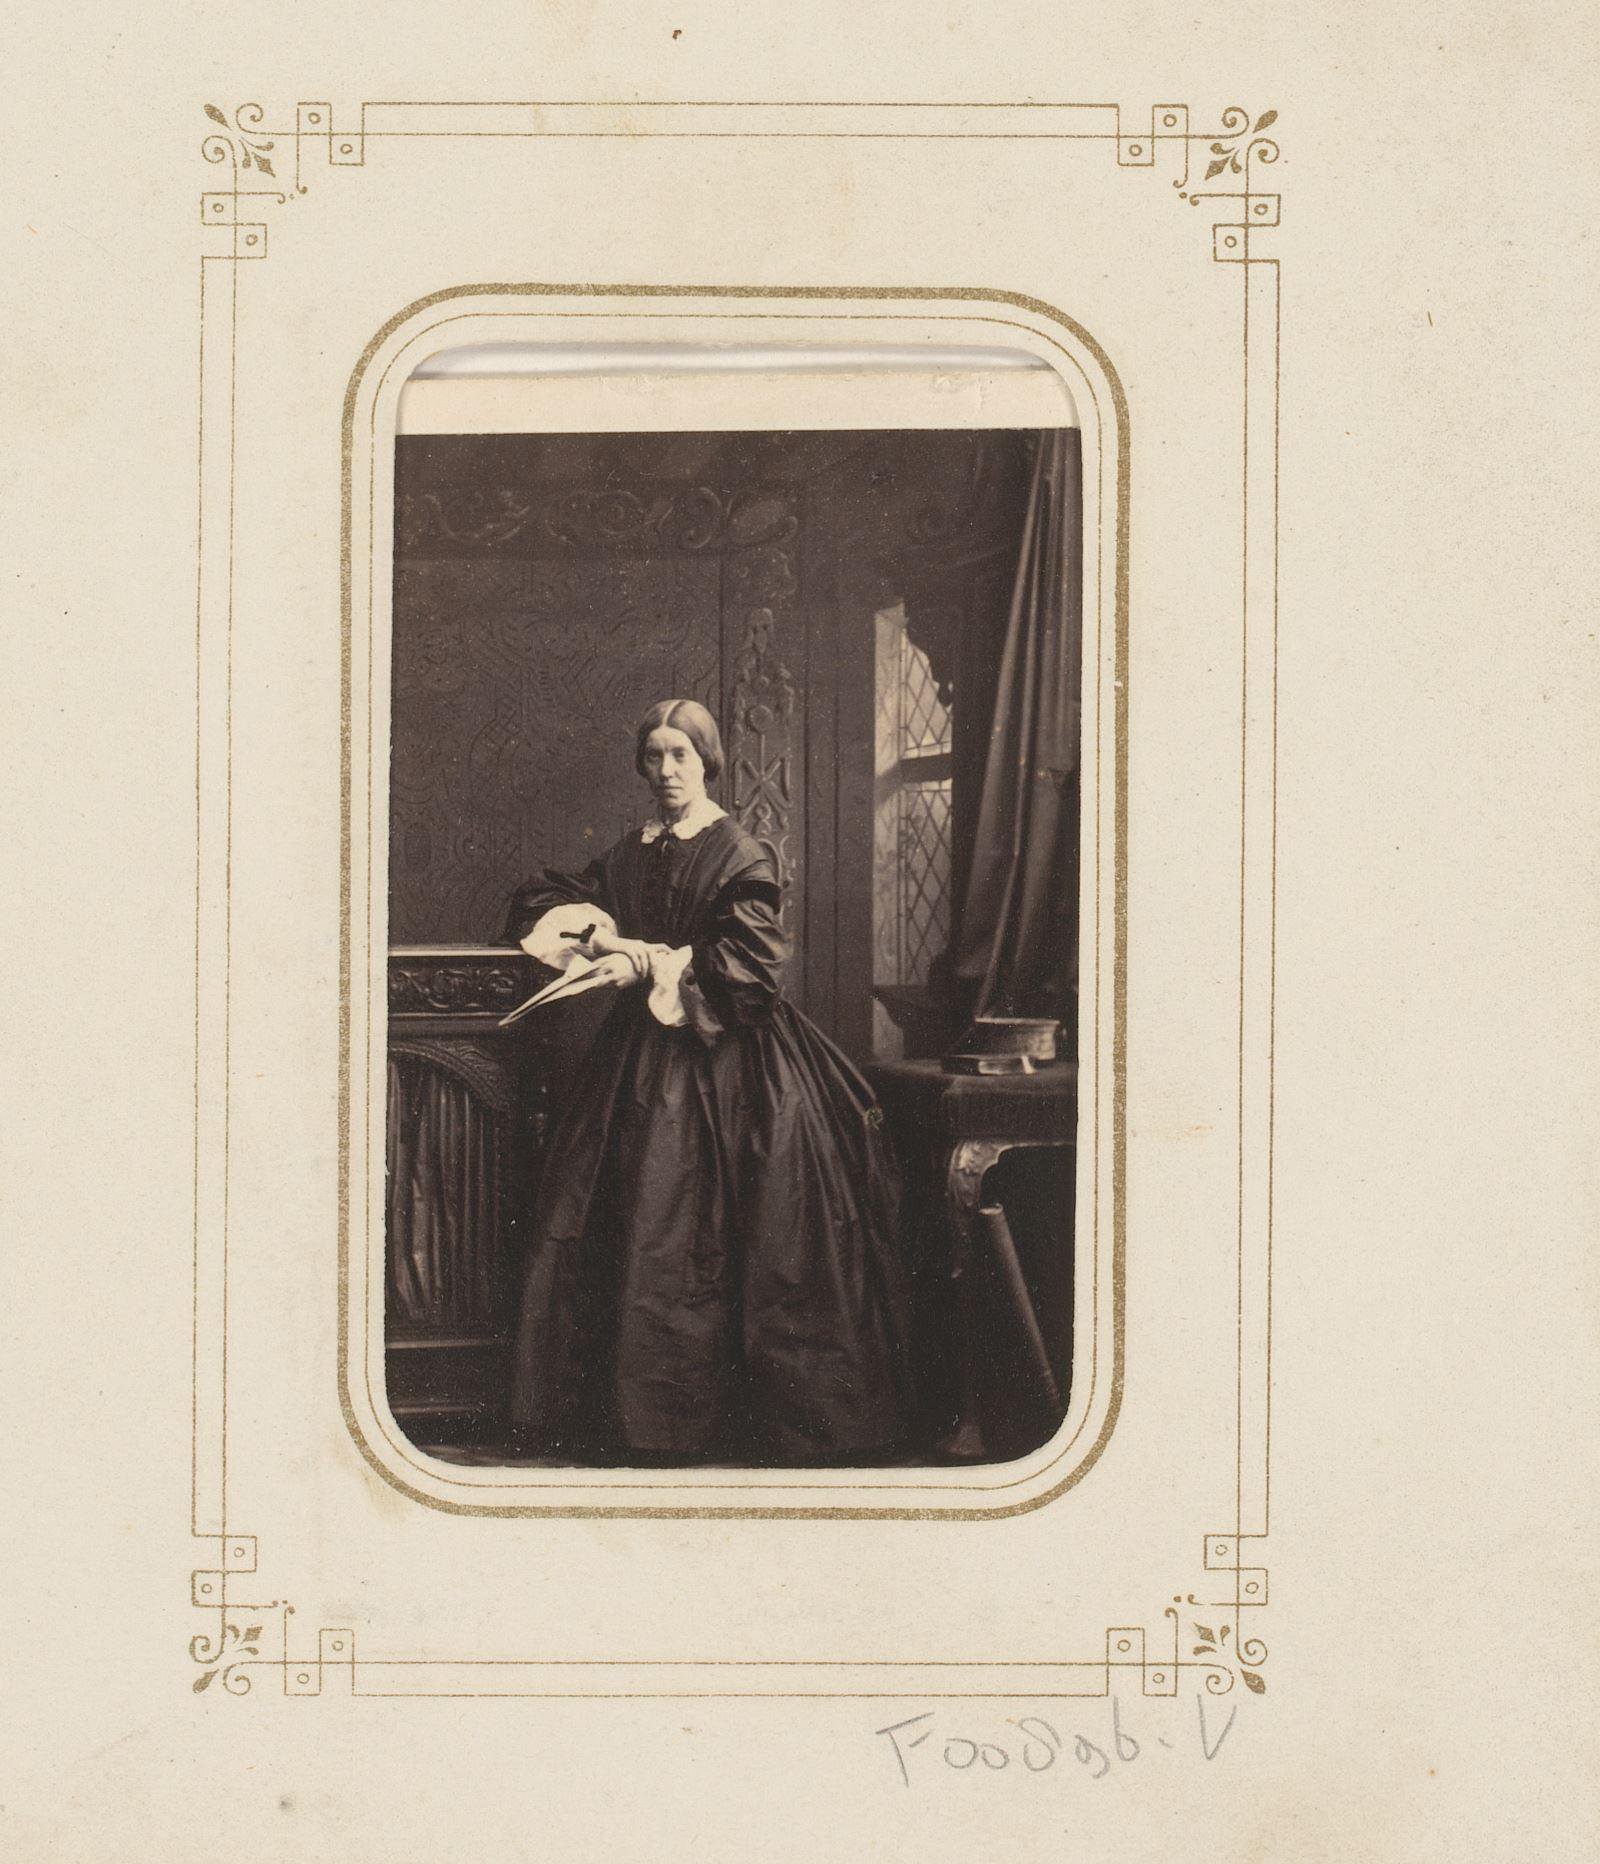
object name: album leaf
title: Portret van een vrouw, staand bij een raam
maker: camille leon louis silvy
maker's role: fotograaf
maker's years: 1834-1910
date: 1859-1869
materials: cardboard, photographic support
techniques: albumen print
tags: window, historical persons, standing figure - aa - female human figure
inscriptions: inscription: ‘Photographed by/ C. Silvy/ 38 Porchester Terrace/ Bayswater. W.’